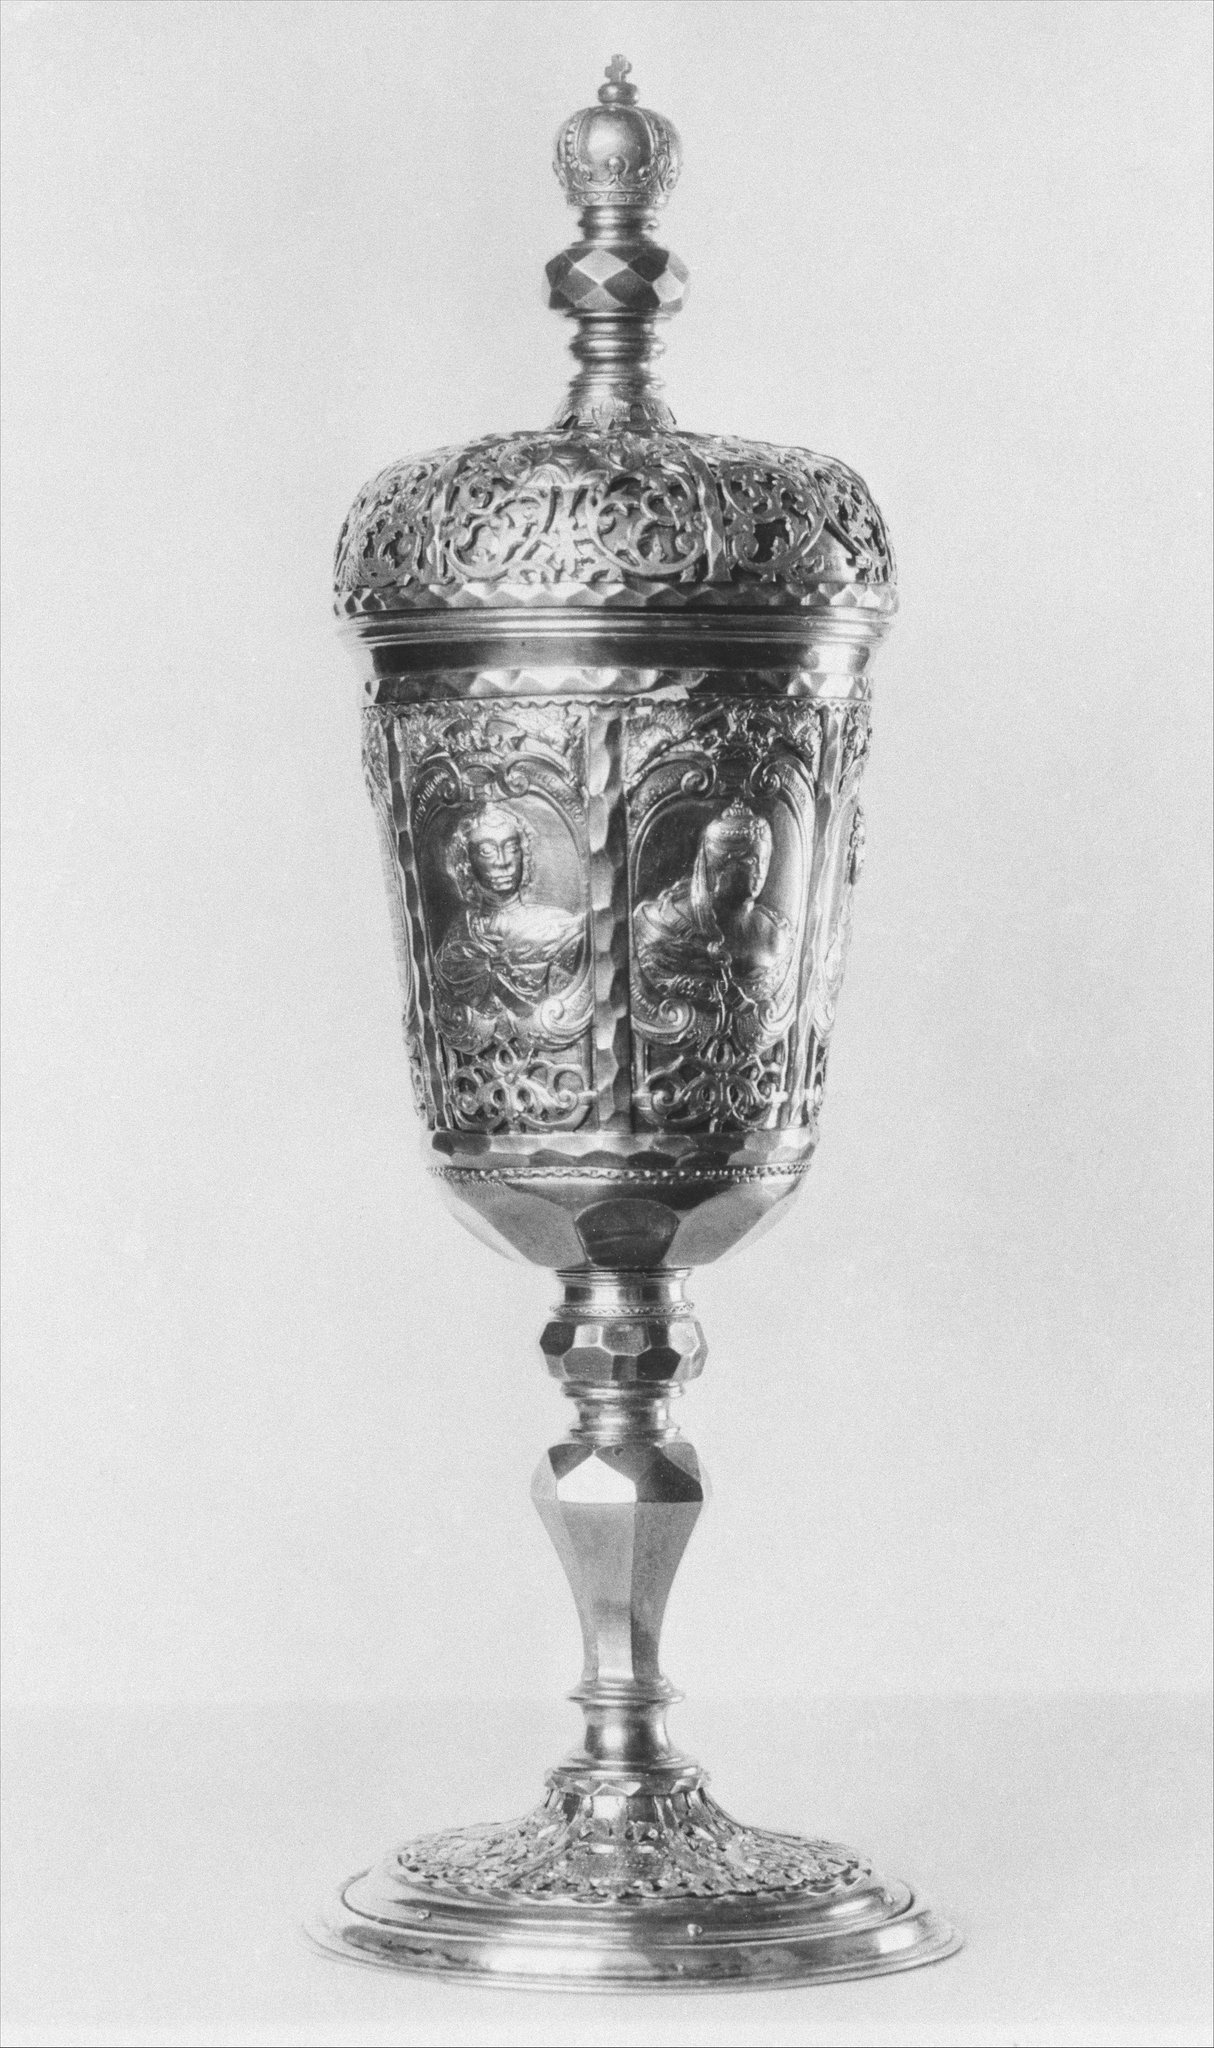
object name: standing cup with cover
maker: basil nikiforoff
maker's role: maker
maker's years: 1700-1800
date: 1737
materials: silver gilt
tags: human figures